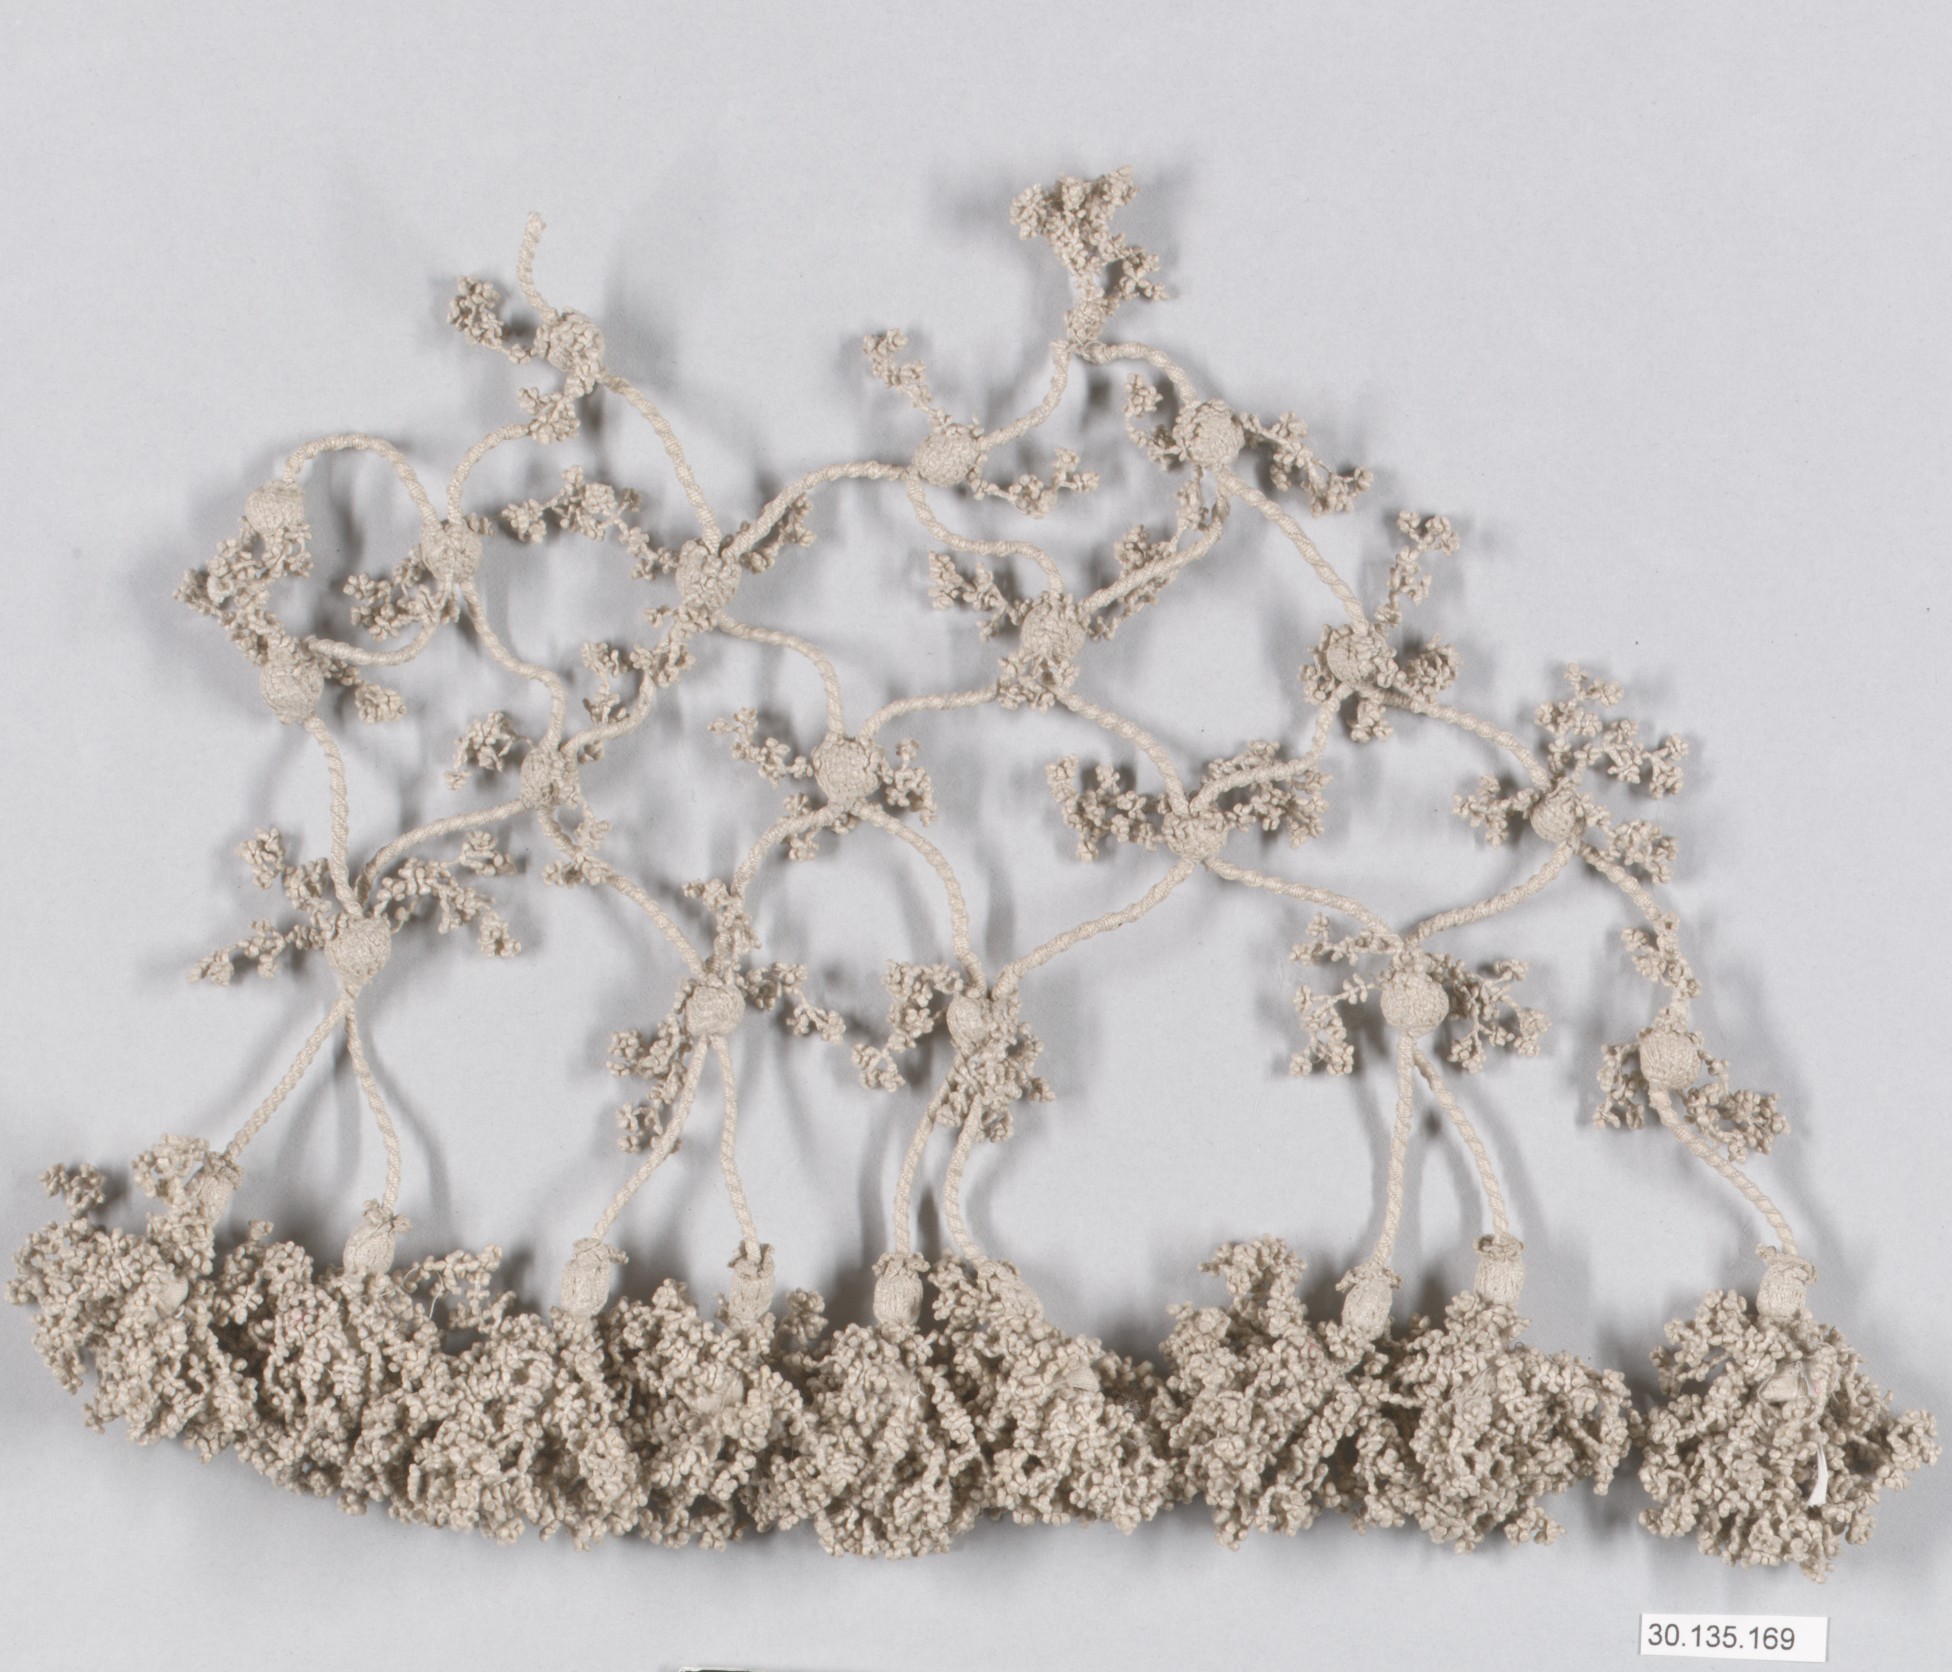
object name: fringe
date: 1601-1700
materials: linen